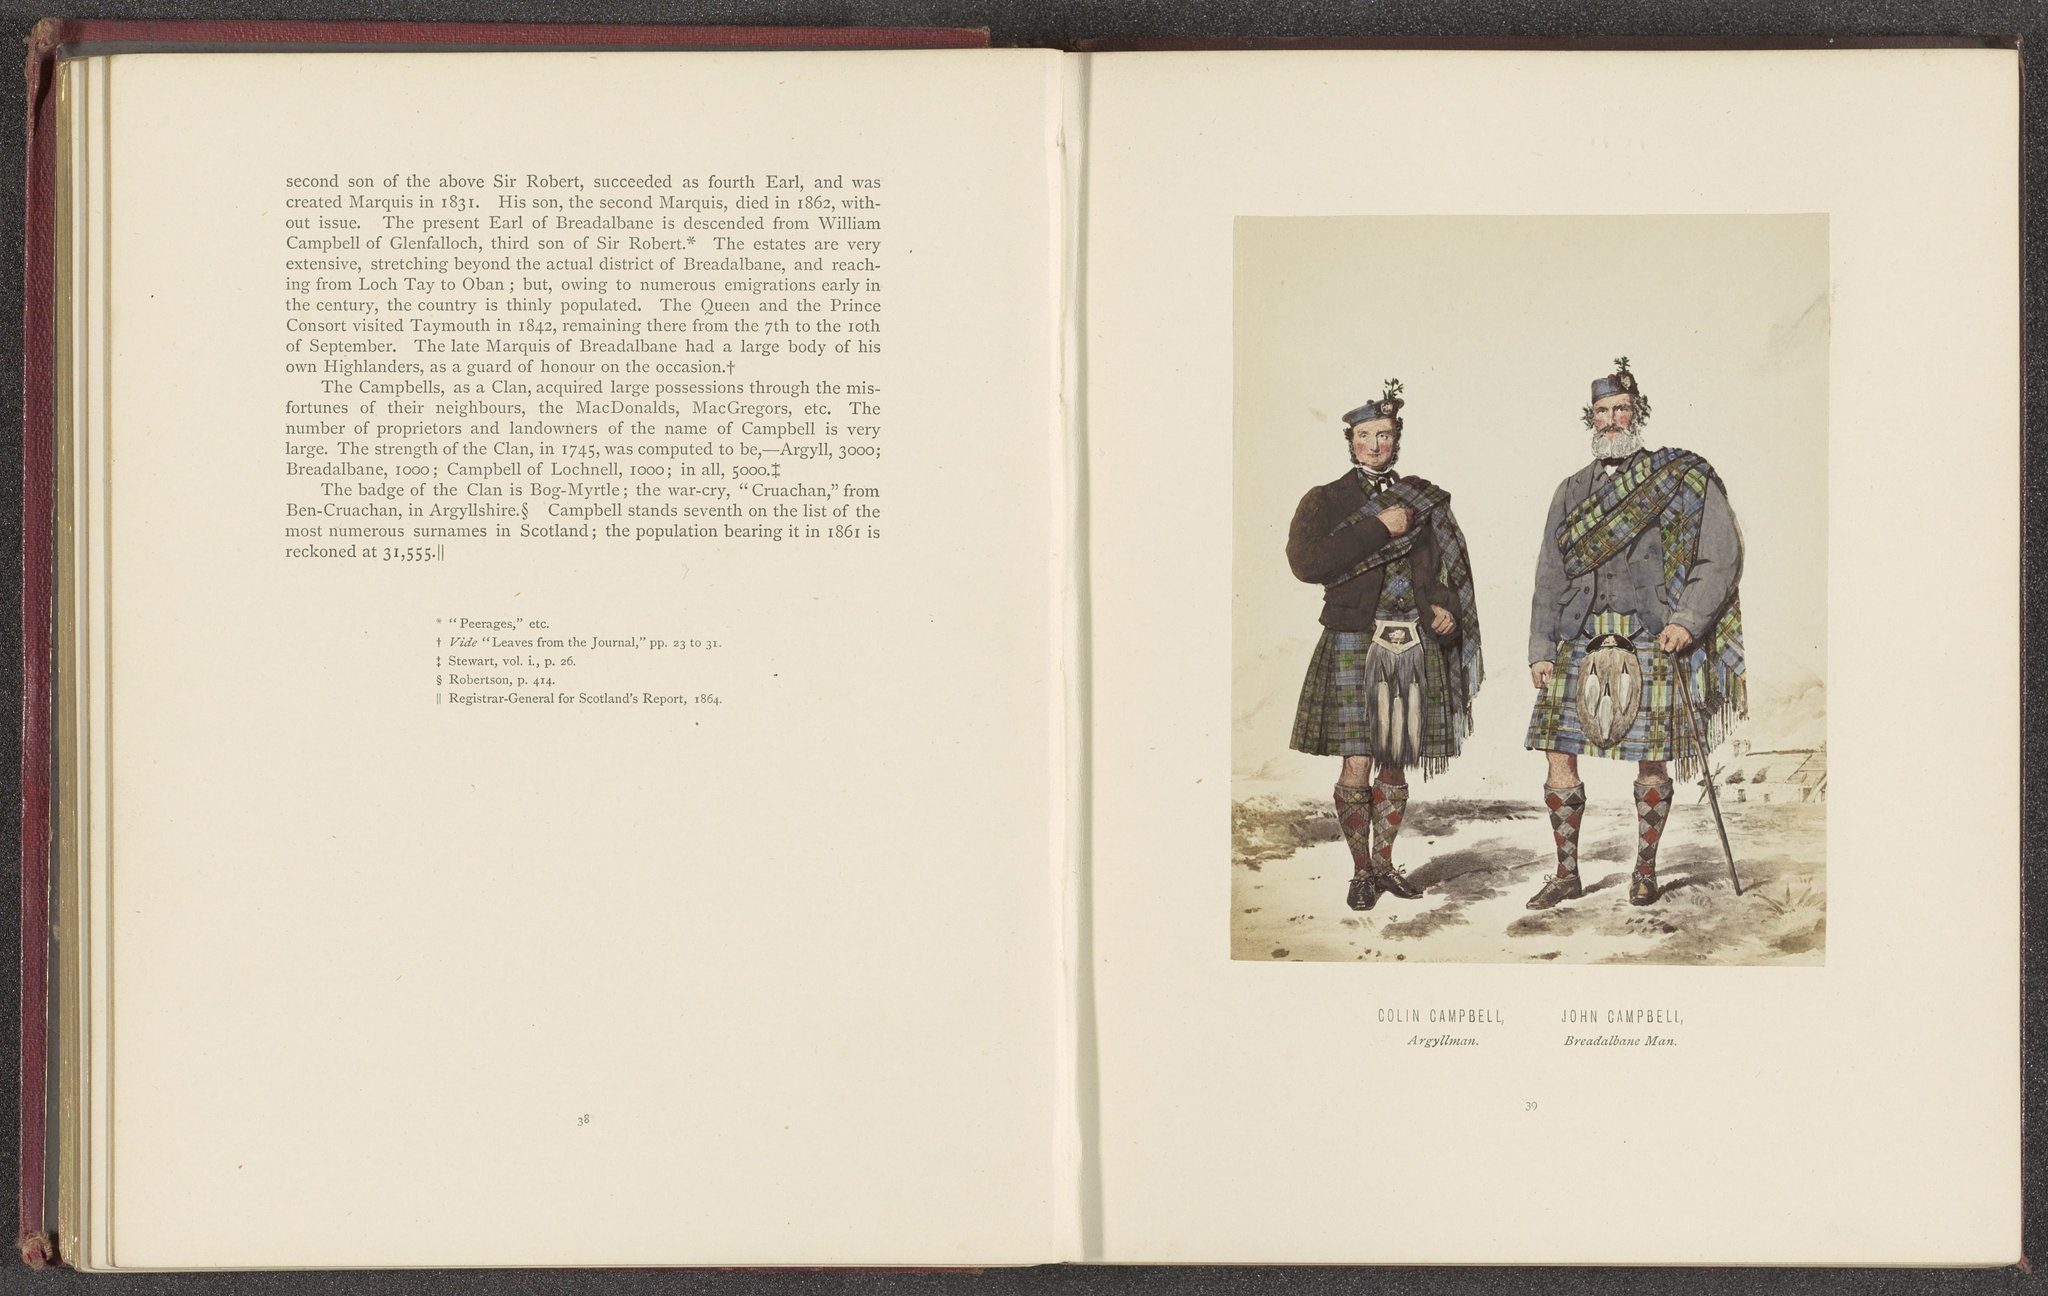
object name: photograph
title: Colin Capbell, Argyllman John Campbell, Breadalbane Man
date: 1860-1870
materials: photographic support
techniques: albumen print, hand coloring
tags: adult man, folk costume, regional costume